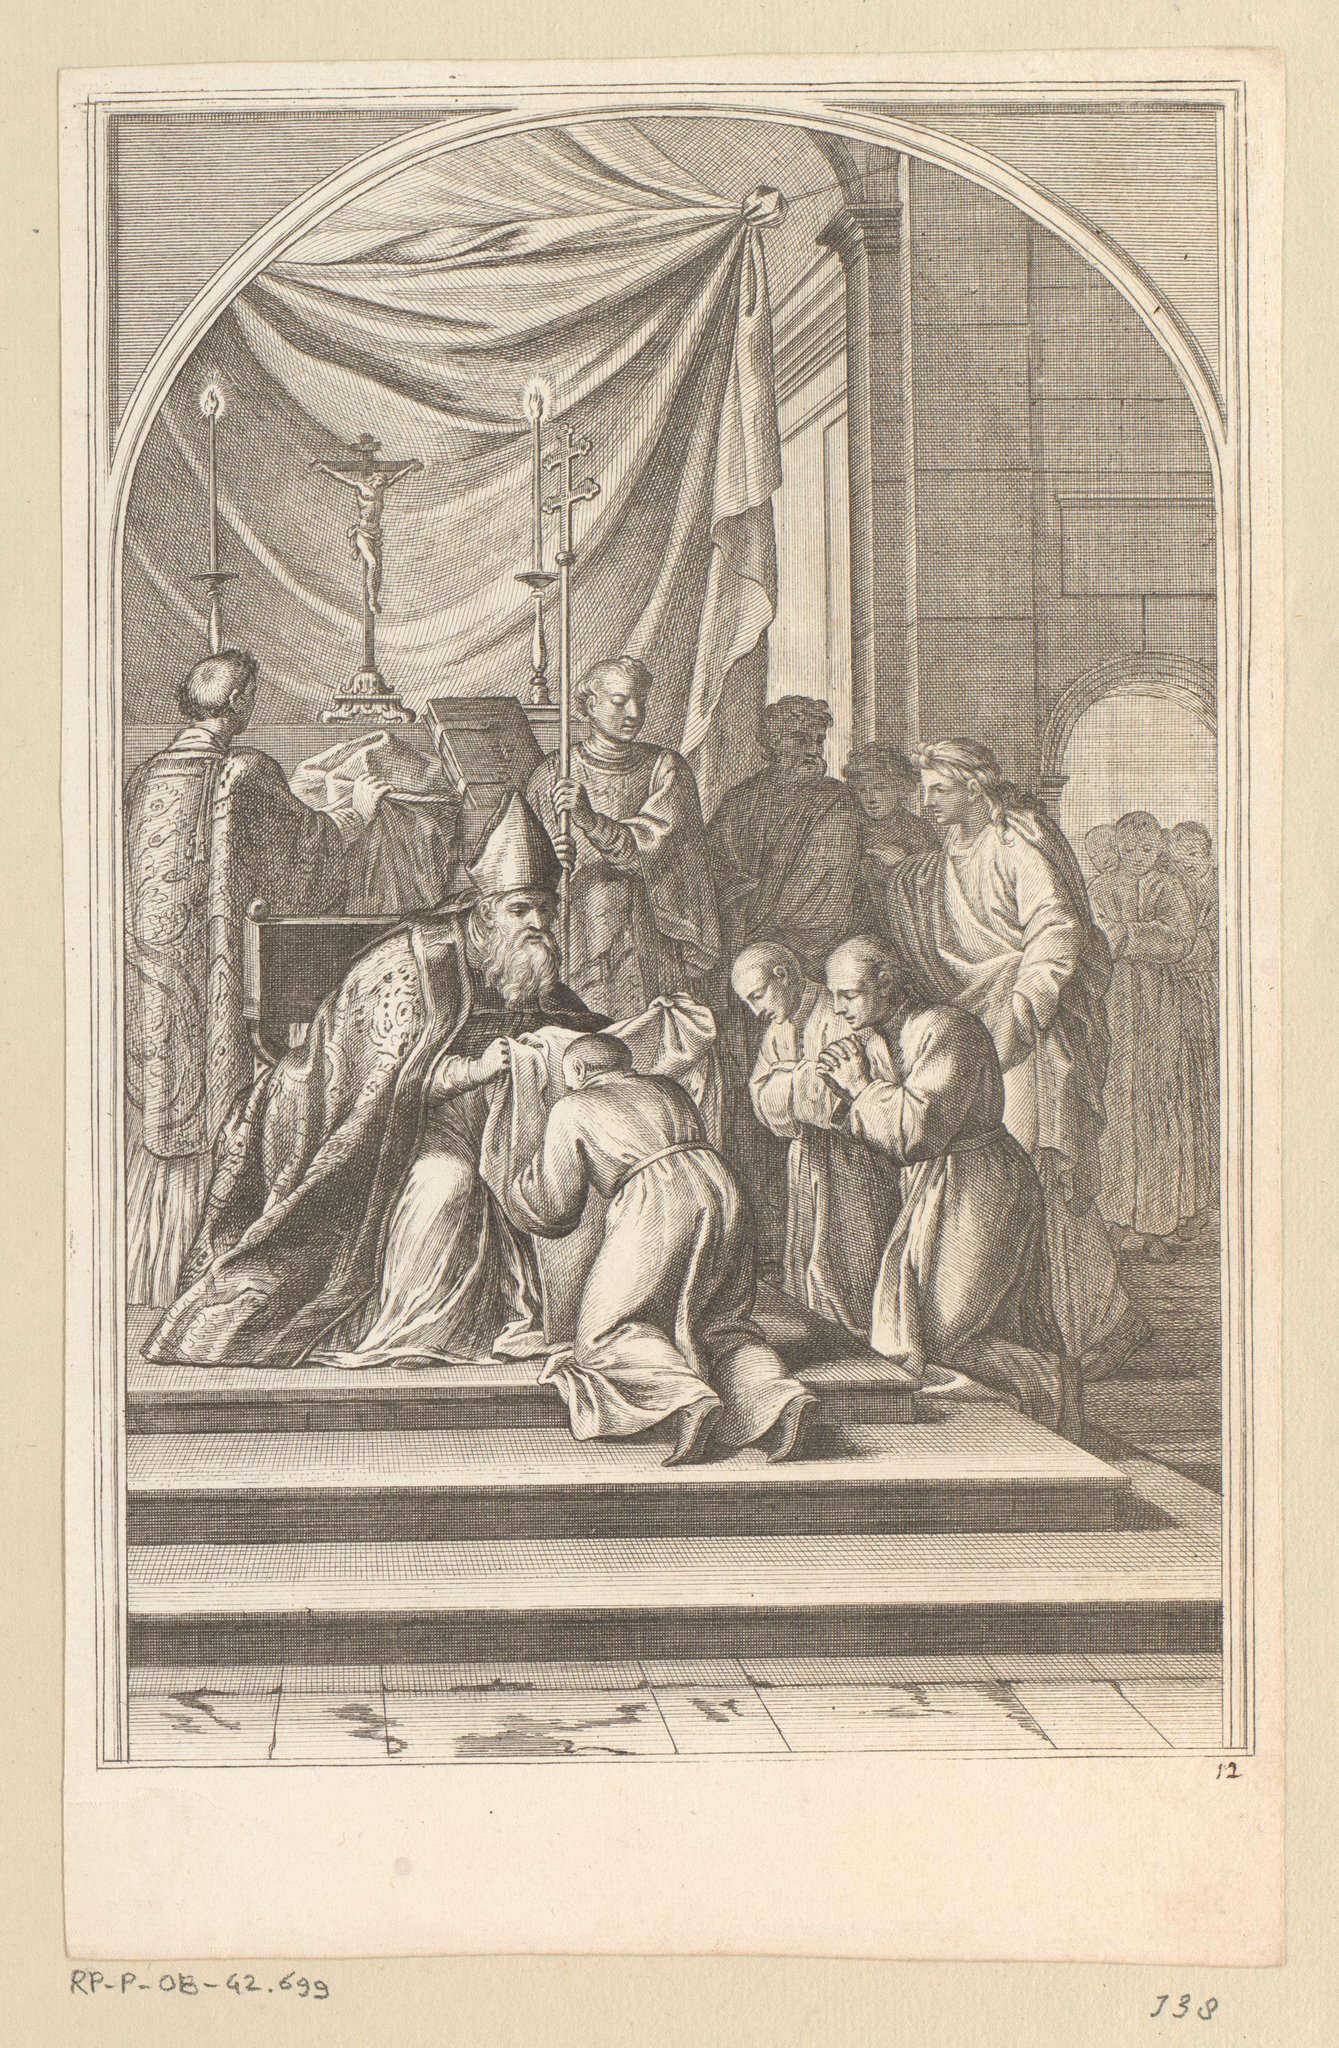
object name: print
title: Heilige Bruno neemt het monnikskleed van de Kartuizers aan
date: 1623-1676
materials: paper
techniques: printmaking, engraving, etching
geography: paris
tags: the founder of the order of the carthusians, bruno; possible attributes: cross, finger at lips, lily, mitre at his feet, olive-branch, ray of light, skull, (seven) star(s)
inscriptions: collector's mark: Lugt 2165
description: Maakt deel uit van een serie met 24 prenten (inclusief twee titelprenten), naar schilderijen door Lesueur vervaardigd tussen 1645-1648 voor de Chartreuse de Paris. De serie is getiteld: La vie de St. Bruno fondateur de l'Ordre des Chartreux peinte au cloistre de la Chartreuse de Paris par Eustache Le Sueur.